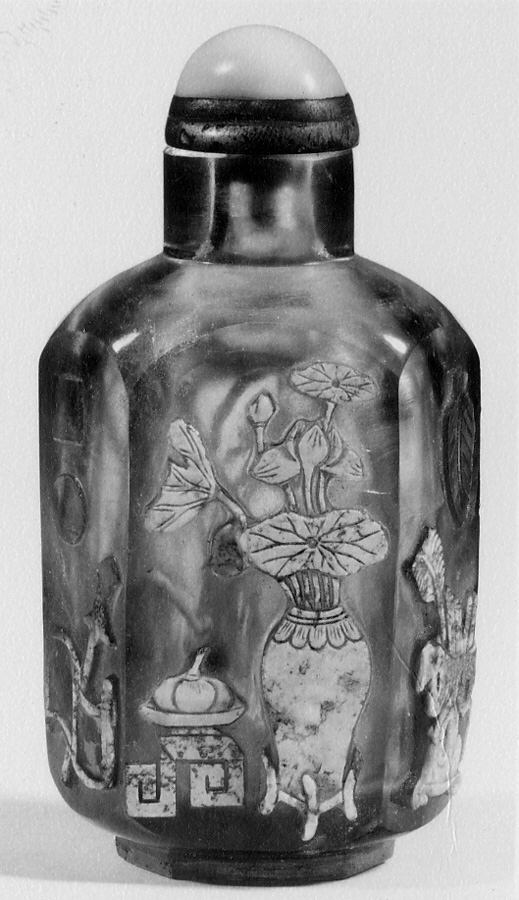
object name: snuff bottle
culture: chinese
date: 1801-1900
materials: glass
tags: flowers